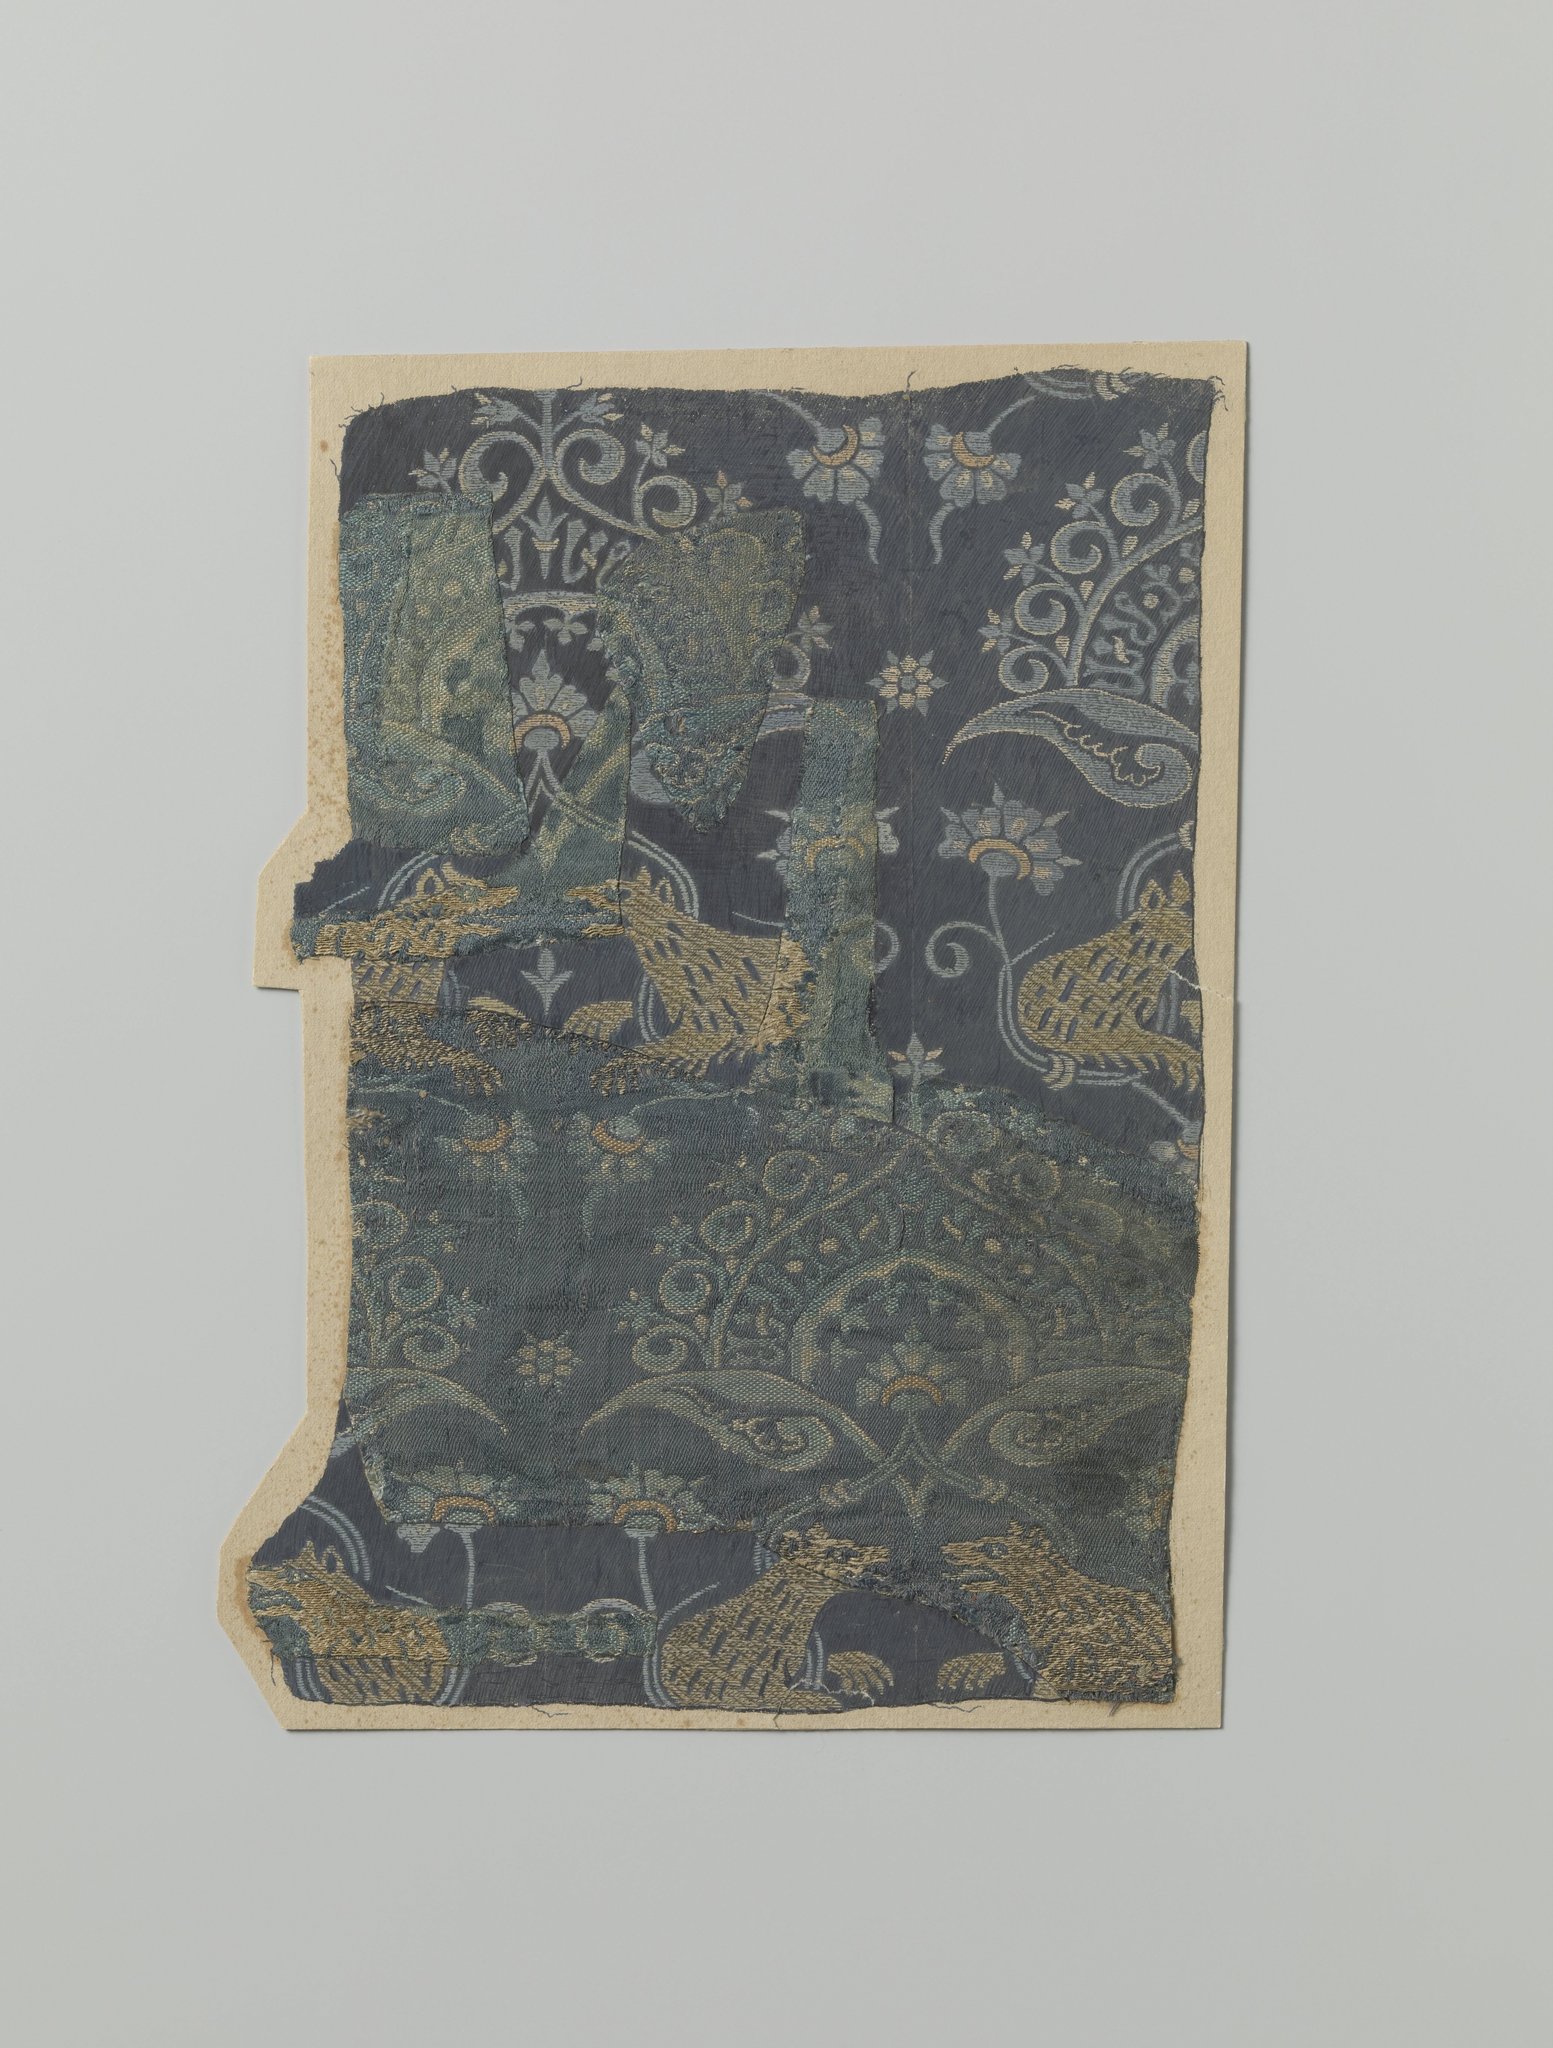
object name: fragment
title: Fragment zijdeweefsel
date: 1200-1299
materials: silk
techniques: weave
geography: italy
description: Fragment, samengesteld uit 7 opgeplakte delen, van grijsblauwe zijde met patroon van palmetvormen en paarsgewijs naar elkaar toegewende wolven. Patroon is bijgetekend.